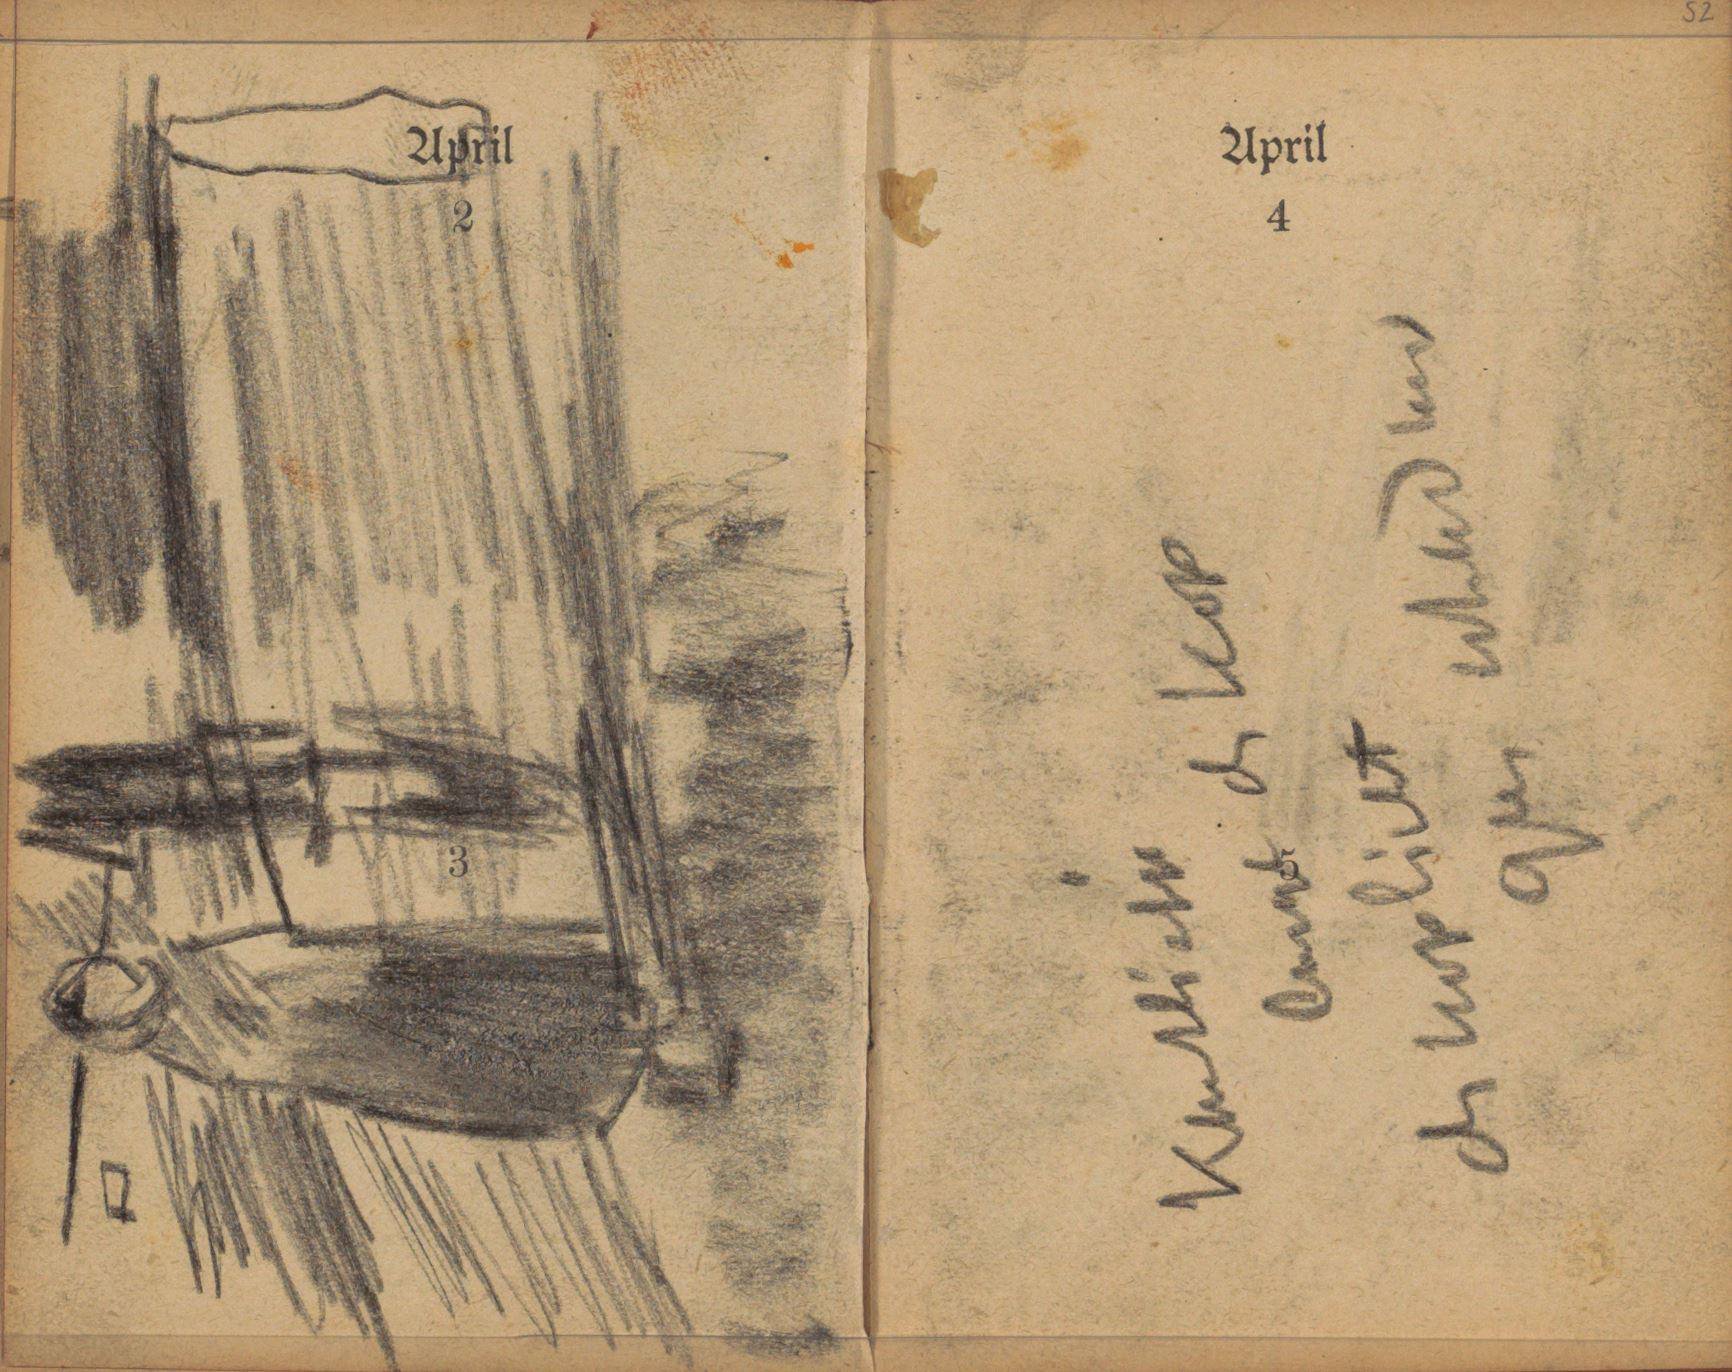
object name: sketchbook leaf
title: Gezicht op een straat met figuren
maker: george hendrik breitner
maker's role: draughtsman, painter, print maker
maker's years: 1857-1923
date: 1893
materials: chalk, paper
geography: amsterdam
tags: street (+ city(-scape) with figures, staffage)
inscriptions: kleurnotitie, handgeschreven: Notities met betrekking tot het licht.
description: Pagina 51 en pagina 52 uit een als schetsboek gebruikte agenda met 80 bladen.